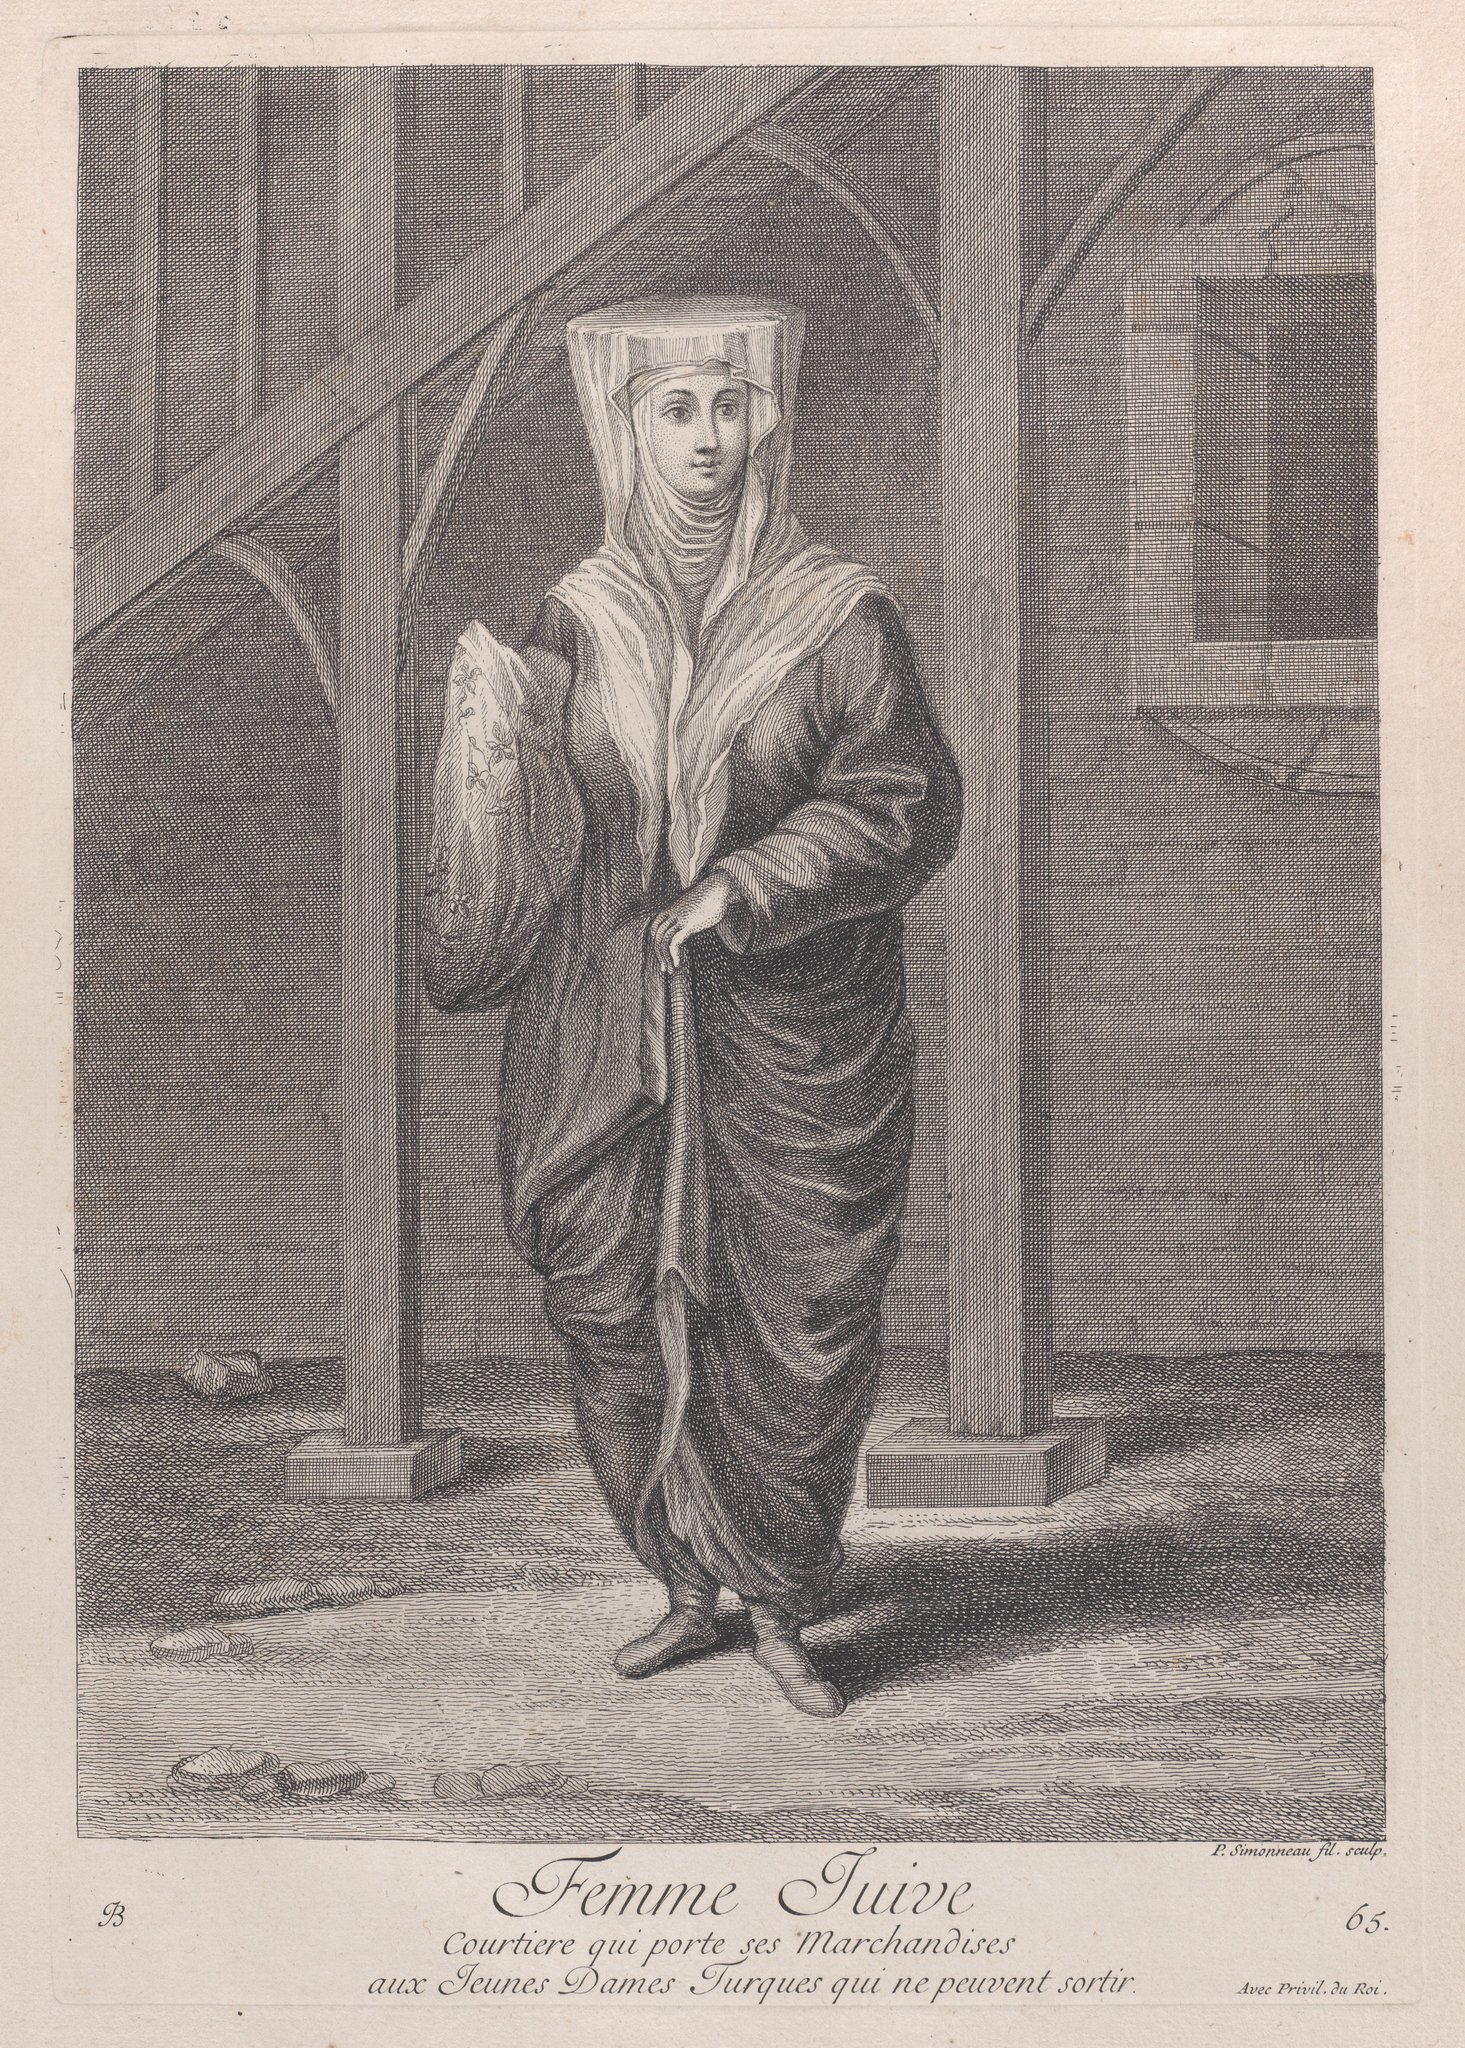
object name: print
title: Femme Juive, Courtiere qui porte ses Marchandises aux Juenes Dames Turques qui ne peuvent sortir, plate 65 from "Recueil de cent estampes représentent differentes nations du Levant"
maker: jean baptiste vanmour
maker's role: artist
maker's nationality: french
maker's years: 1671-1737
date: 1714-1715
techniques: engraving, etching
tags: women